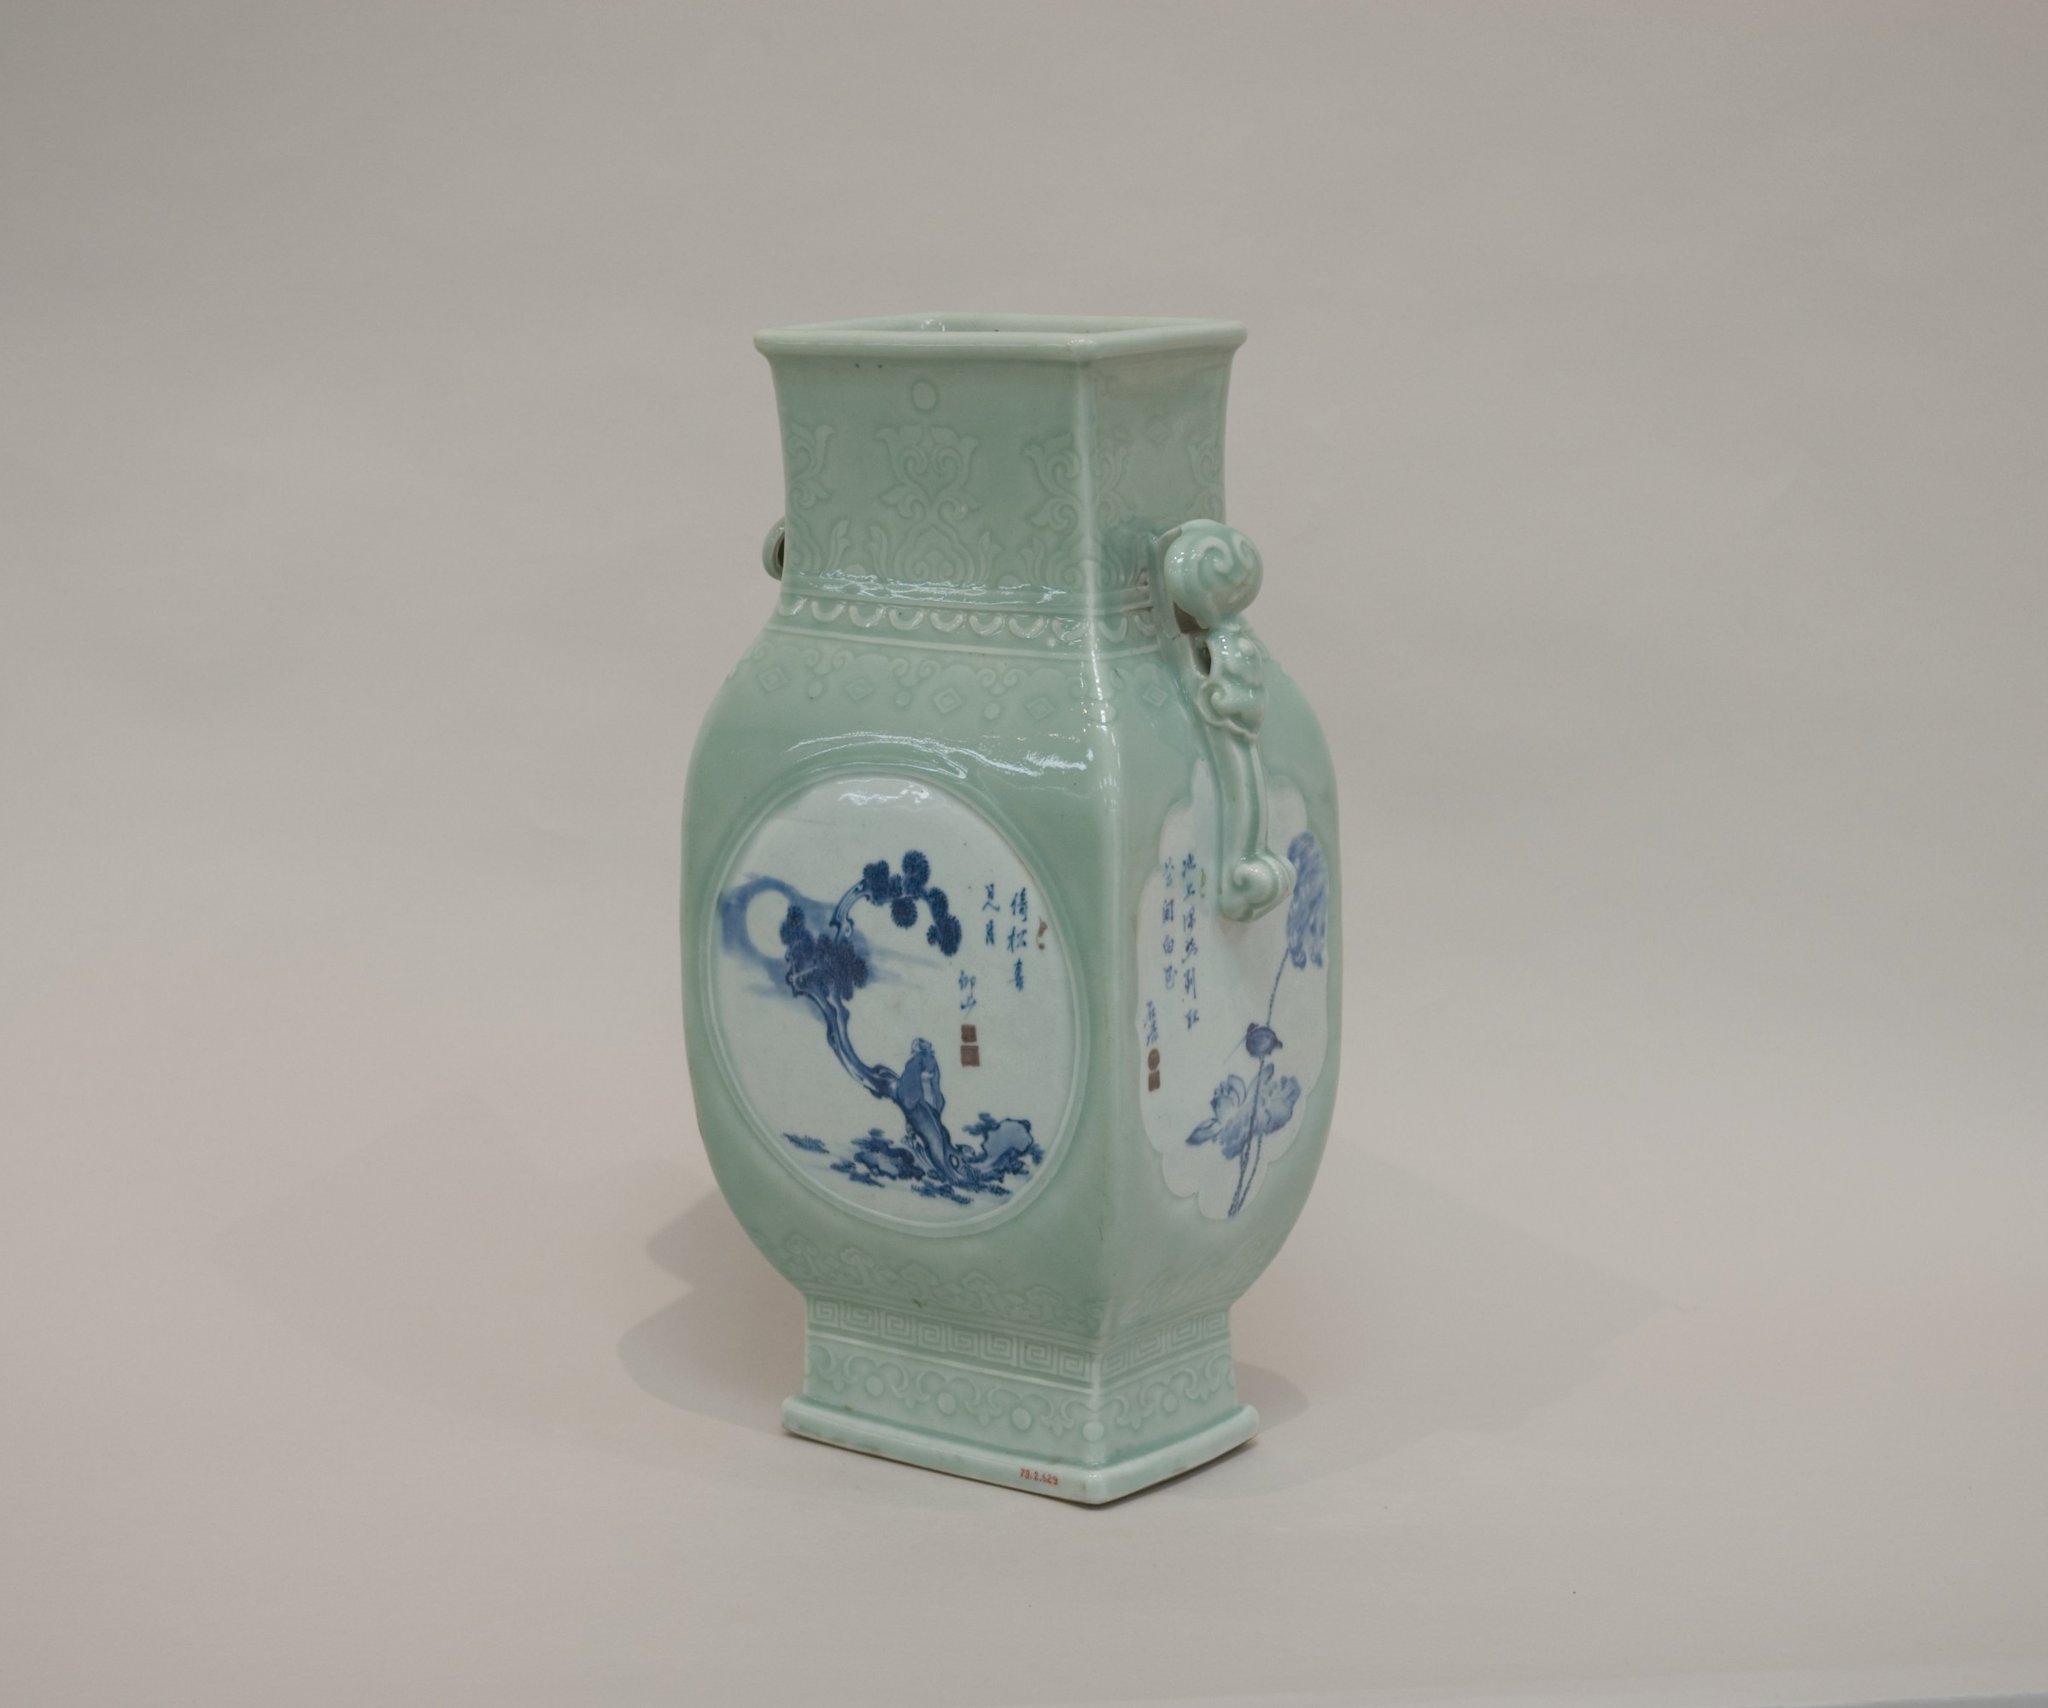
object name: vase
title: Vase with poetric scenes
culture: chinese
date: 1767-1800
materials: ceramic glaze, cobalt, copper, glaze, porcelain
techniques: painting, relief, underglaze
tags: trees